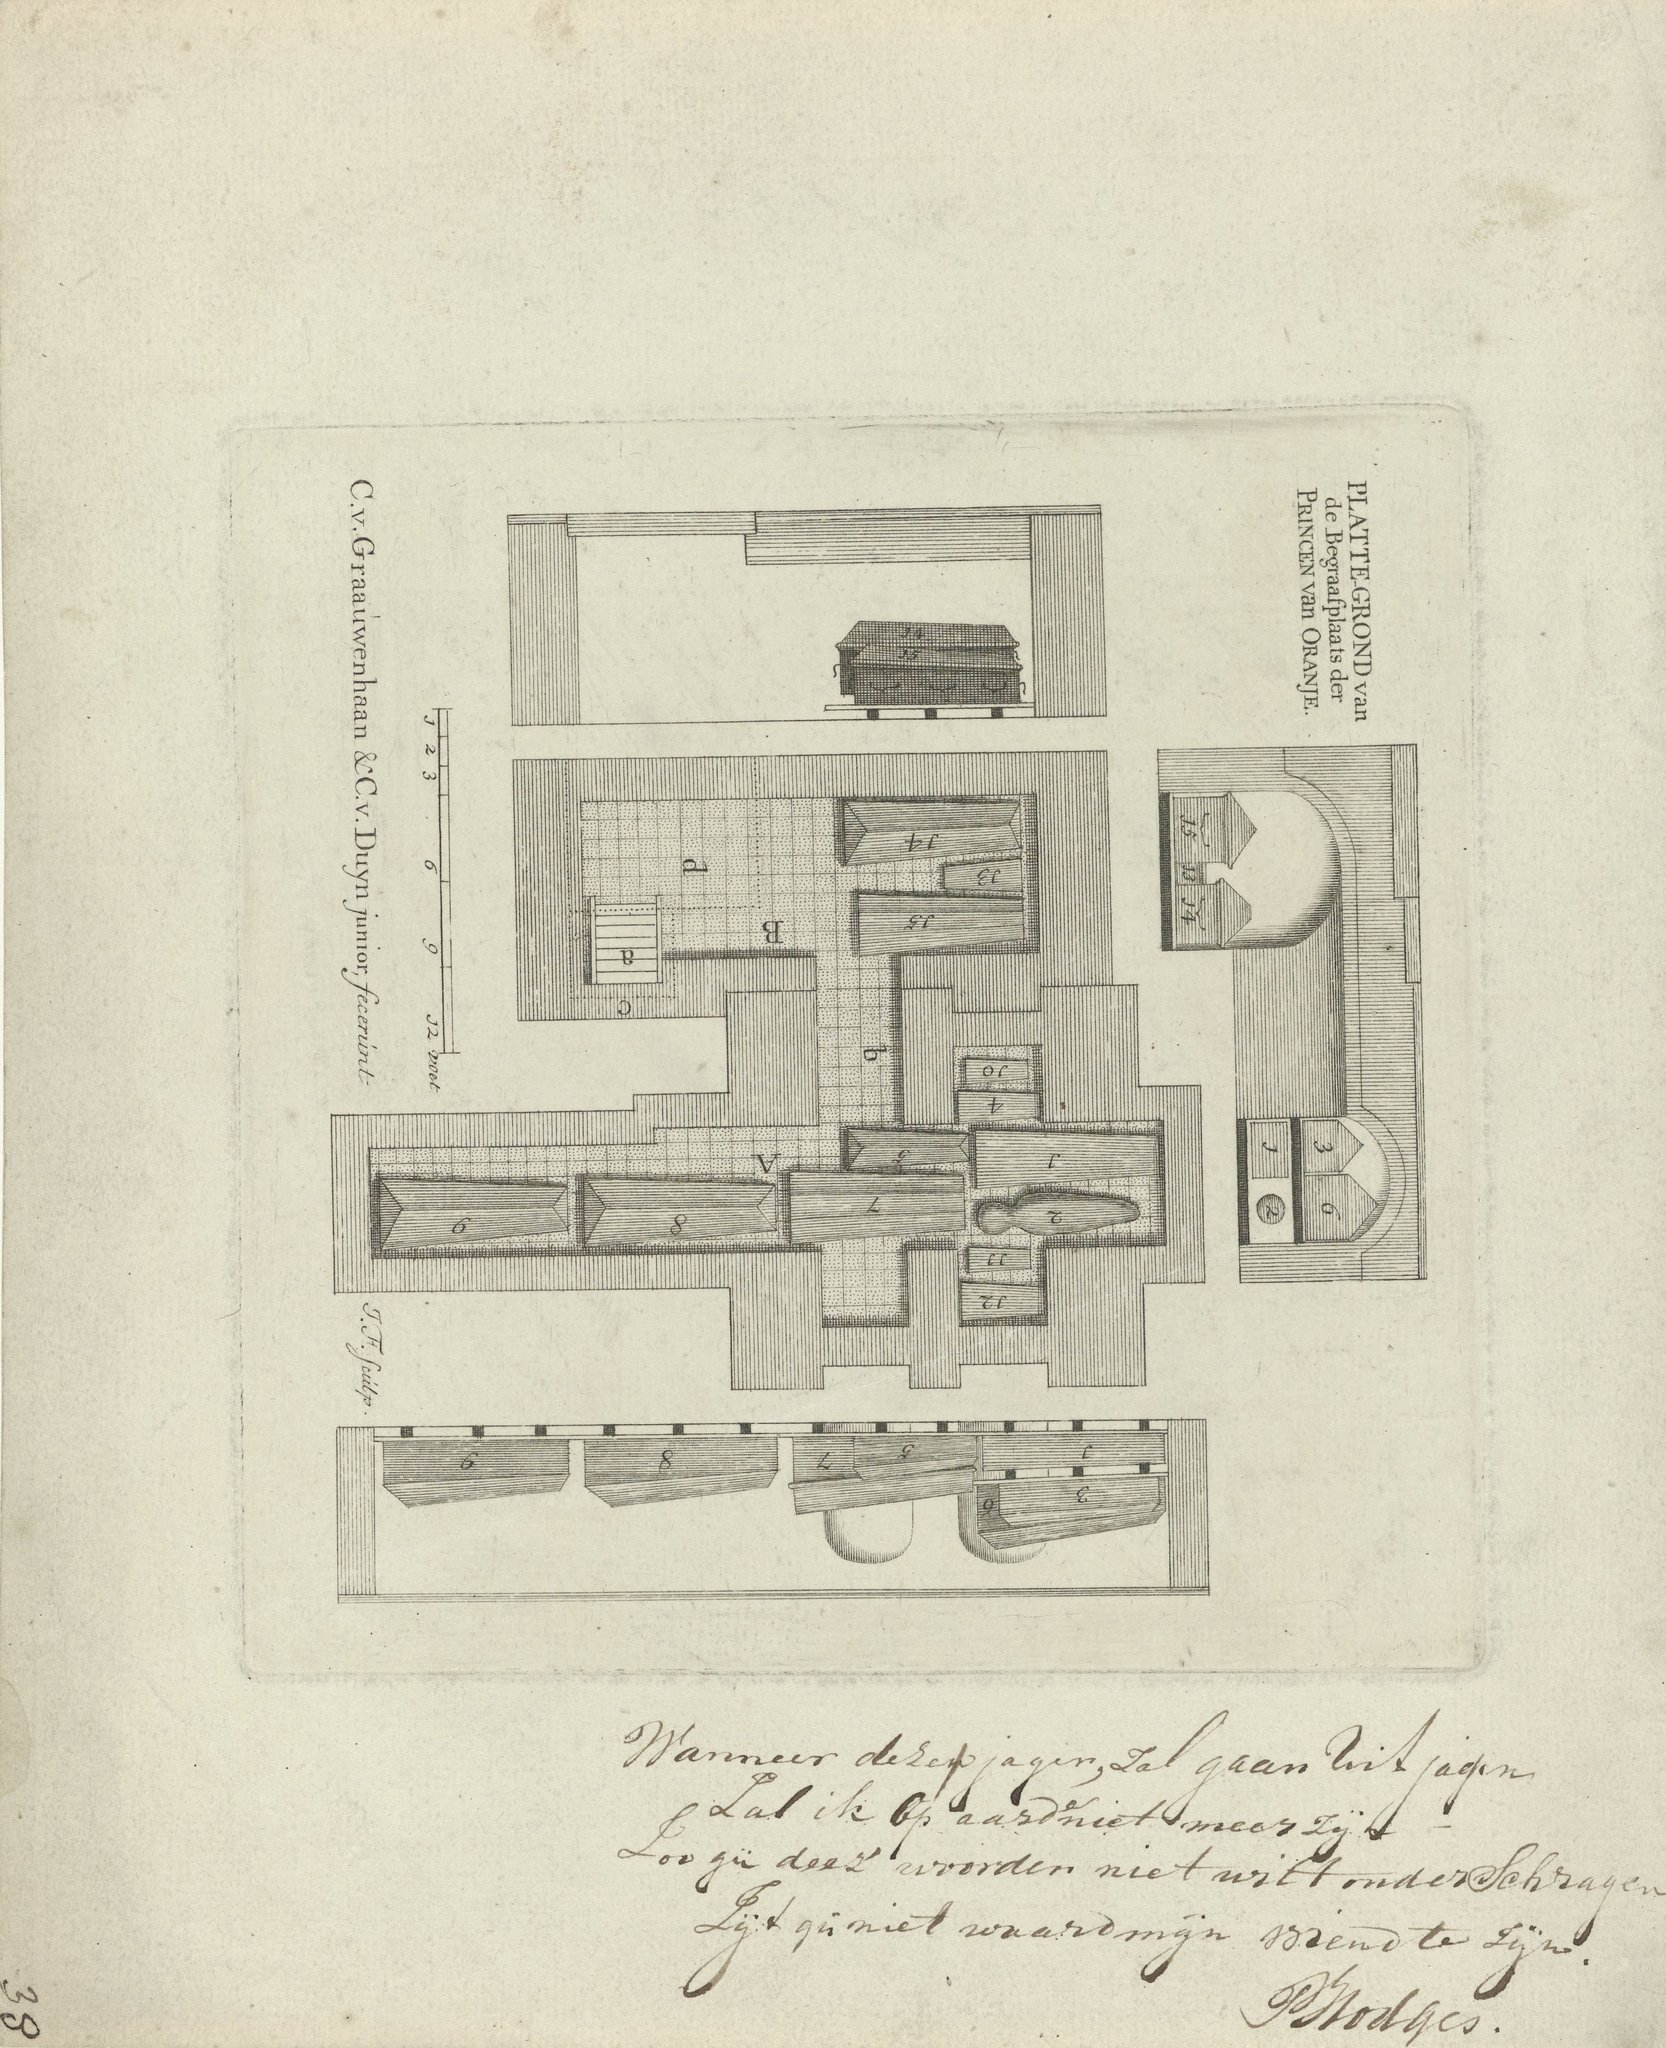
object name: print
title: Plattegrond van de grafkelder van het Huis Oranje-Nassau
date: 1759-1790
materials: paper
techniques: etching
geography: delft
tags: interior of church, grave-building, monumental tomb, delft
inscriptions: inscription: ‘Wanneer deze jager ...’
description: Plattegrond en doorsneden van de grafkelder van het Huis Oranje-Nassau onder de Nieuwe Kerk te Delft met de daarin geplaatste kisten, voorzien van nummers en letters.